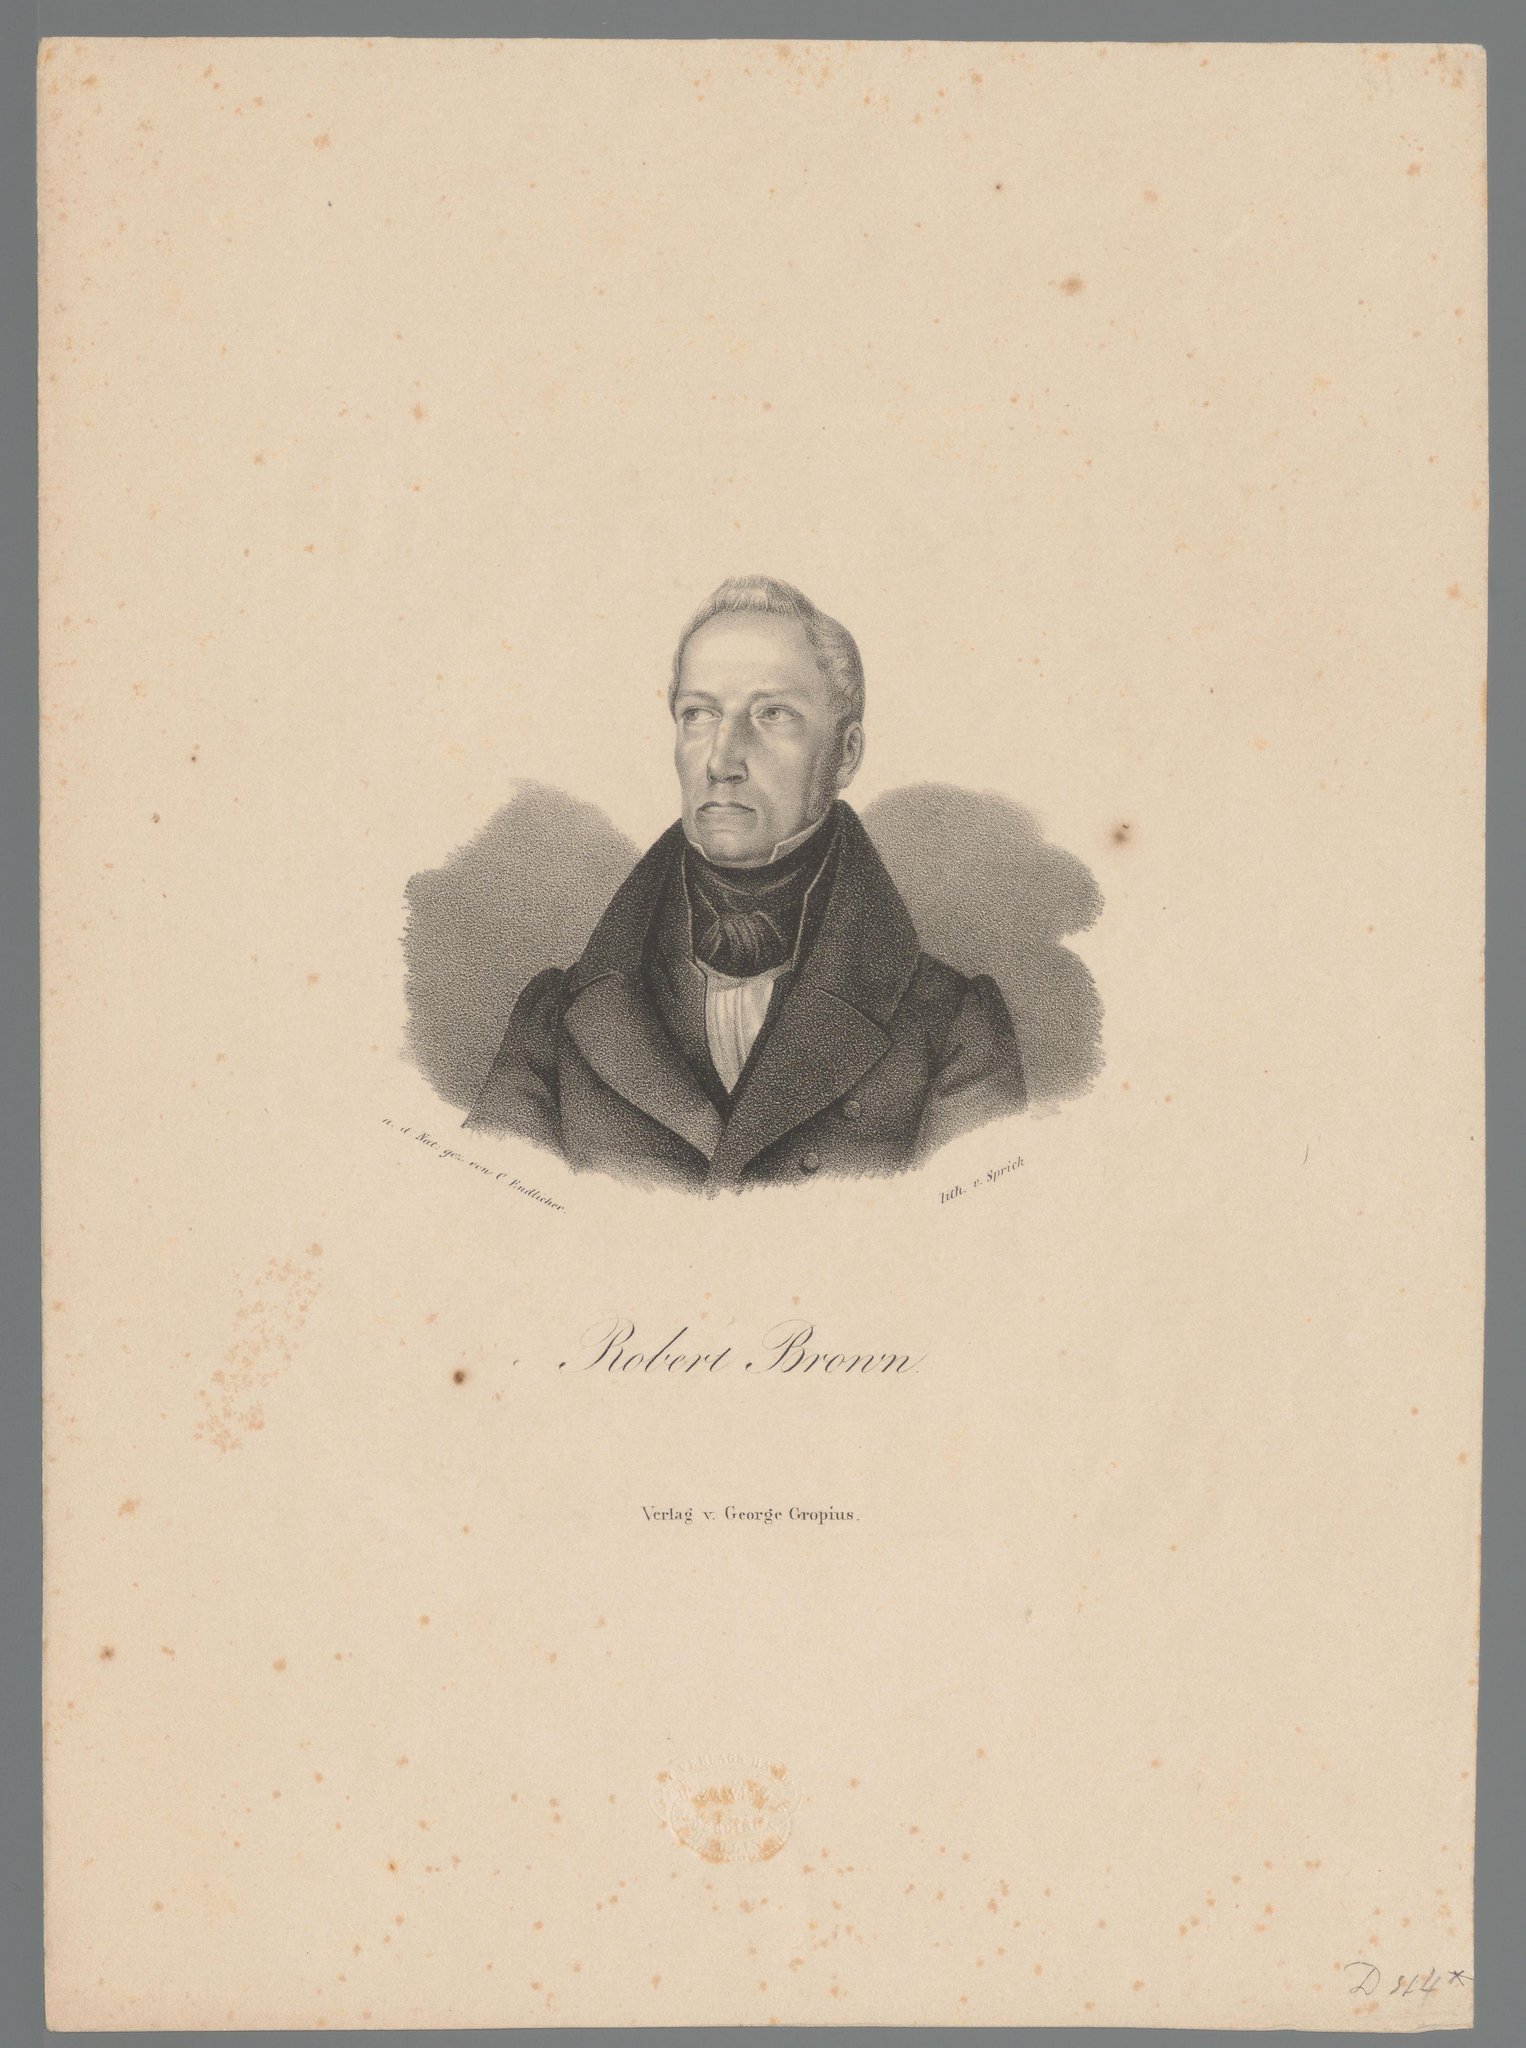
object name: print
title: Portret van Robert Bronn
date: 1815-1840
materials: paper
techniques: lithograph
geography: berlin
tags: adult man, historical persons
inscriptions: check stamp: Lugt 4607, collector's mark: Lugt 2228, check stamp: Lugt 4861